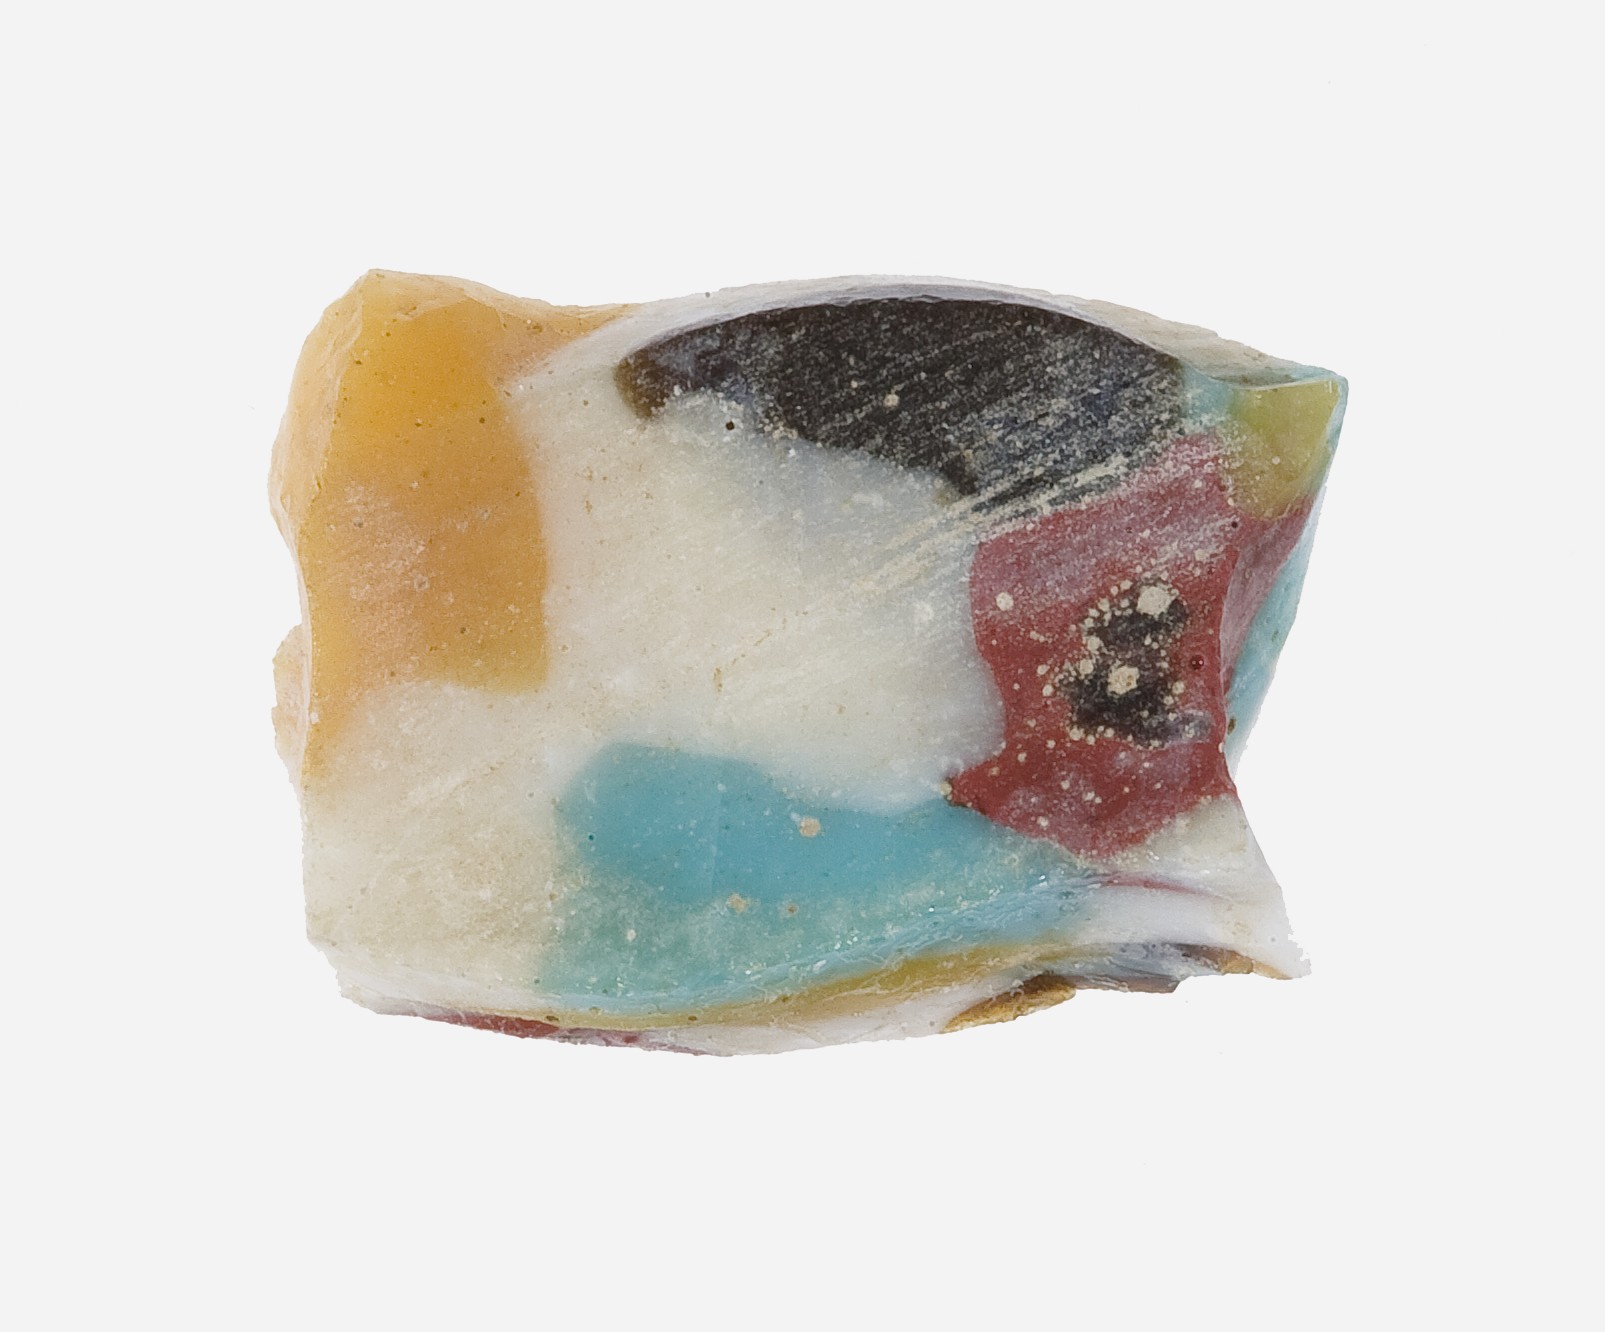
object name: vessel fragment, mosaic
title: Fragment of a Dish of Polychrome Mosaic Glass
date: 1390-1352 BCE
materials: glass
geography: egypt